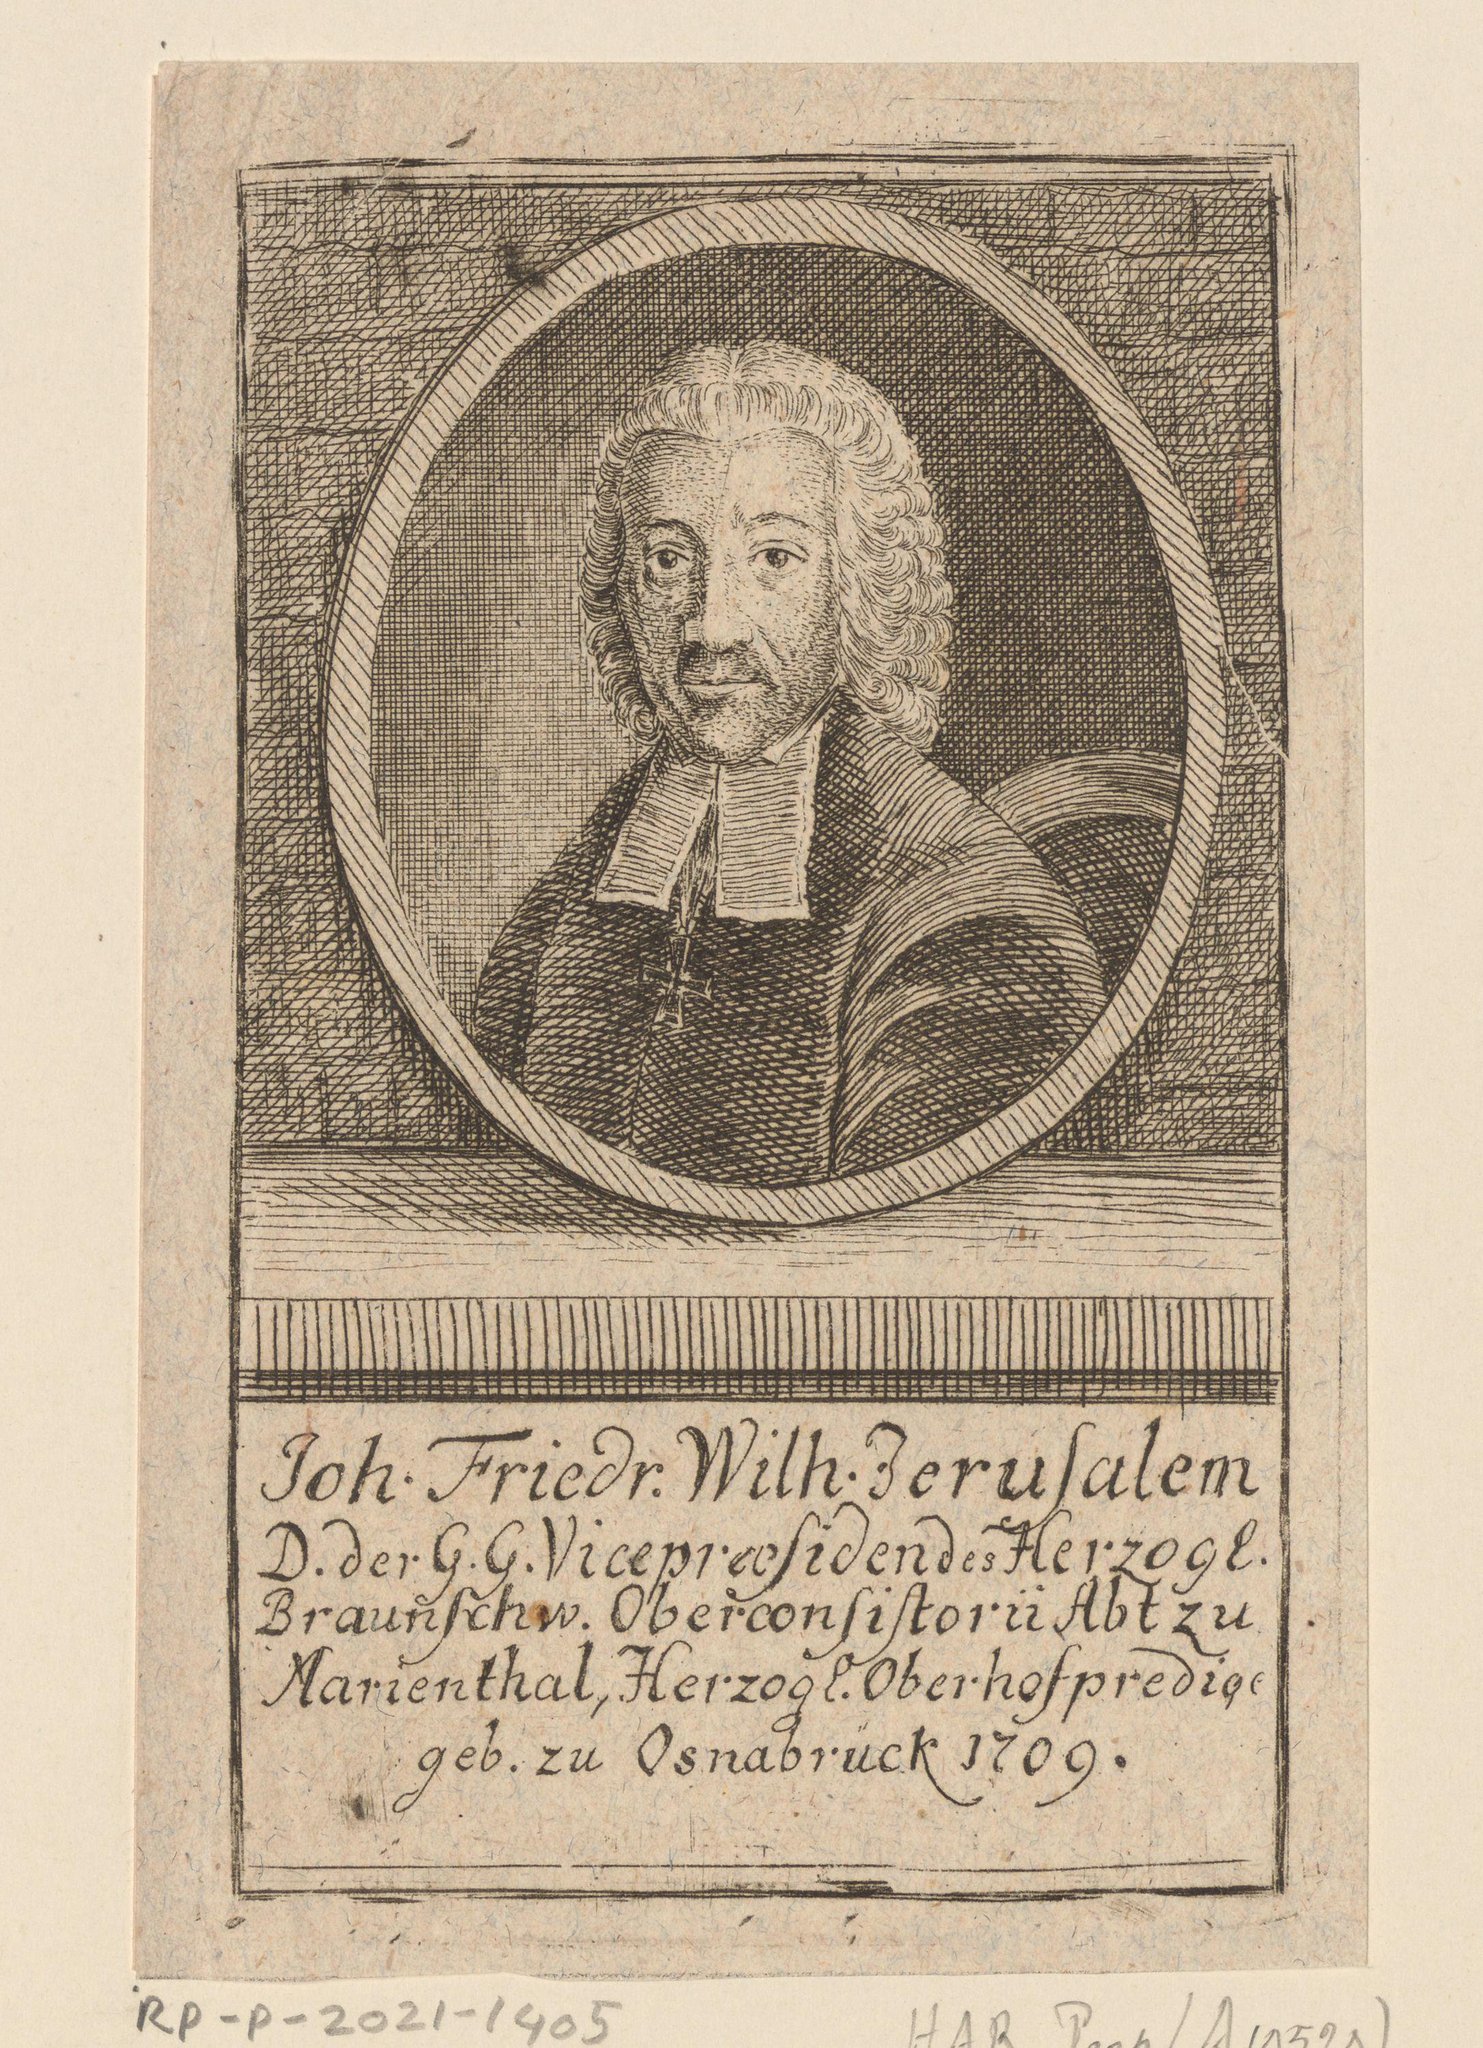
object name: print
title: Portret van Johann Friedrich Wilhelm Jerusalem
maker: Anonymous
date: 1752-1799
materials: paper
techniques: etching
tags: theologian, historical persons